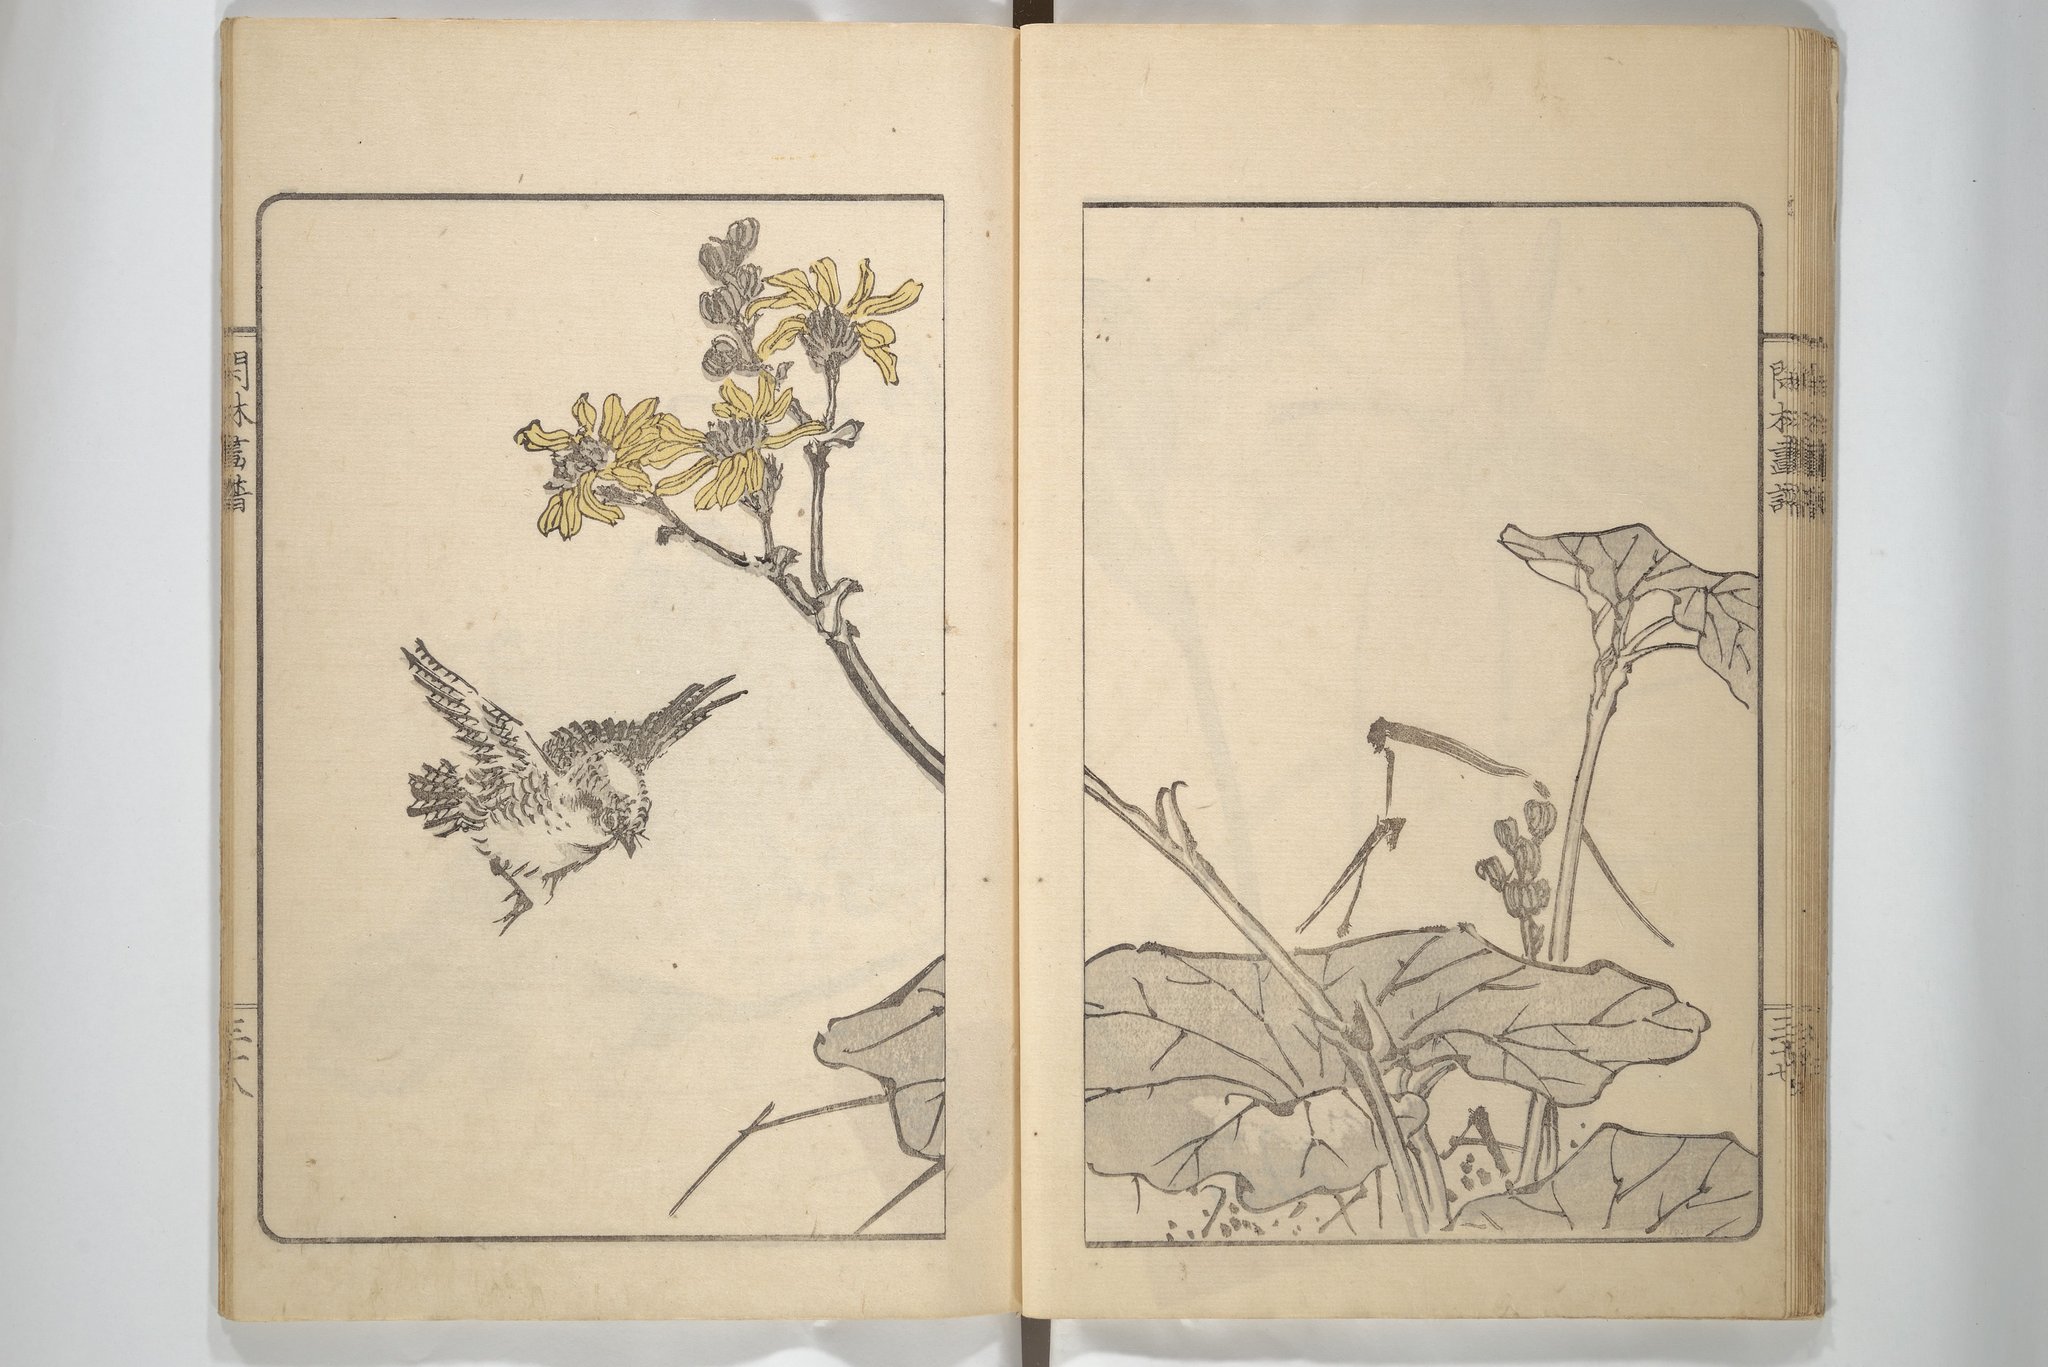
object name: illustrated book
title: Kanrin Picture Album (Kanrin gafu) 閑林画譜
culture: japanese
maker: okada kanrin 岡田閑林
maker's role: artist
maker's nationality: japanese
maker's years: 1775-1849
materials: ink, paper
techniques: woodblock print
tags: birds,flowers,leaves